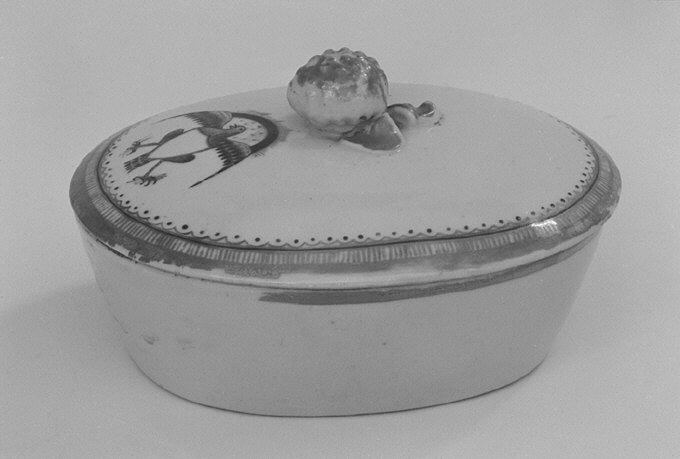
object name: dish with cover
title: Dish with cover (part of a service)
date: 1767-1833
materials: hard paste porcelain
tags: coat of arms